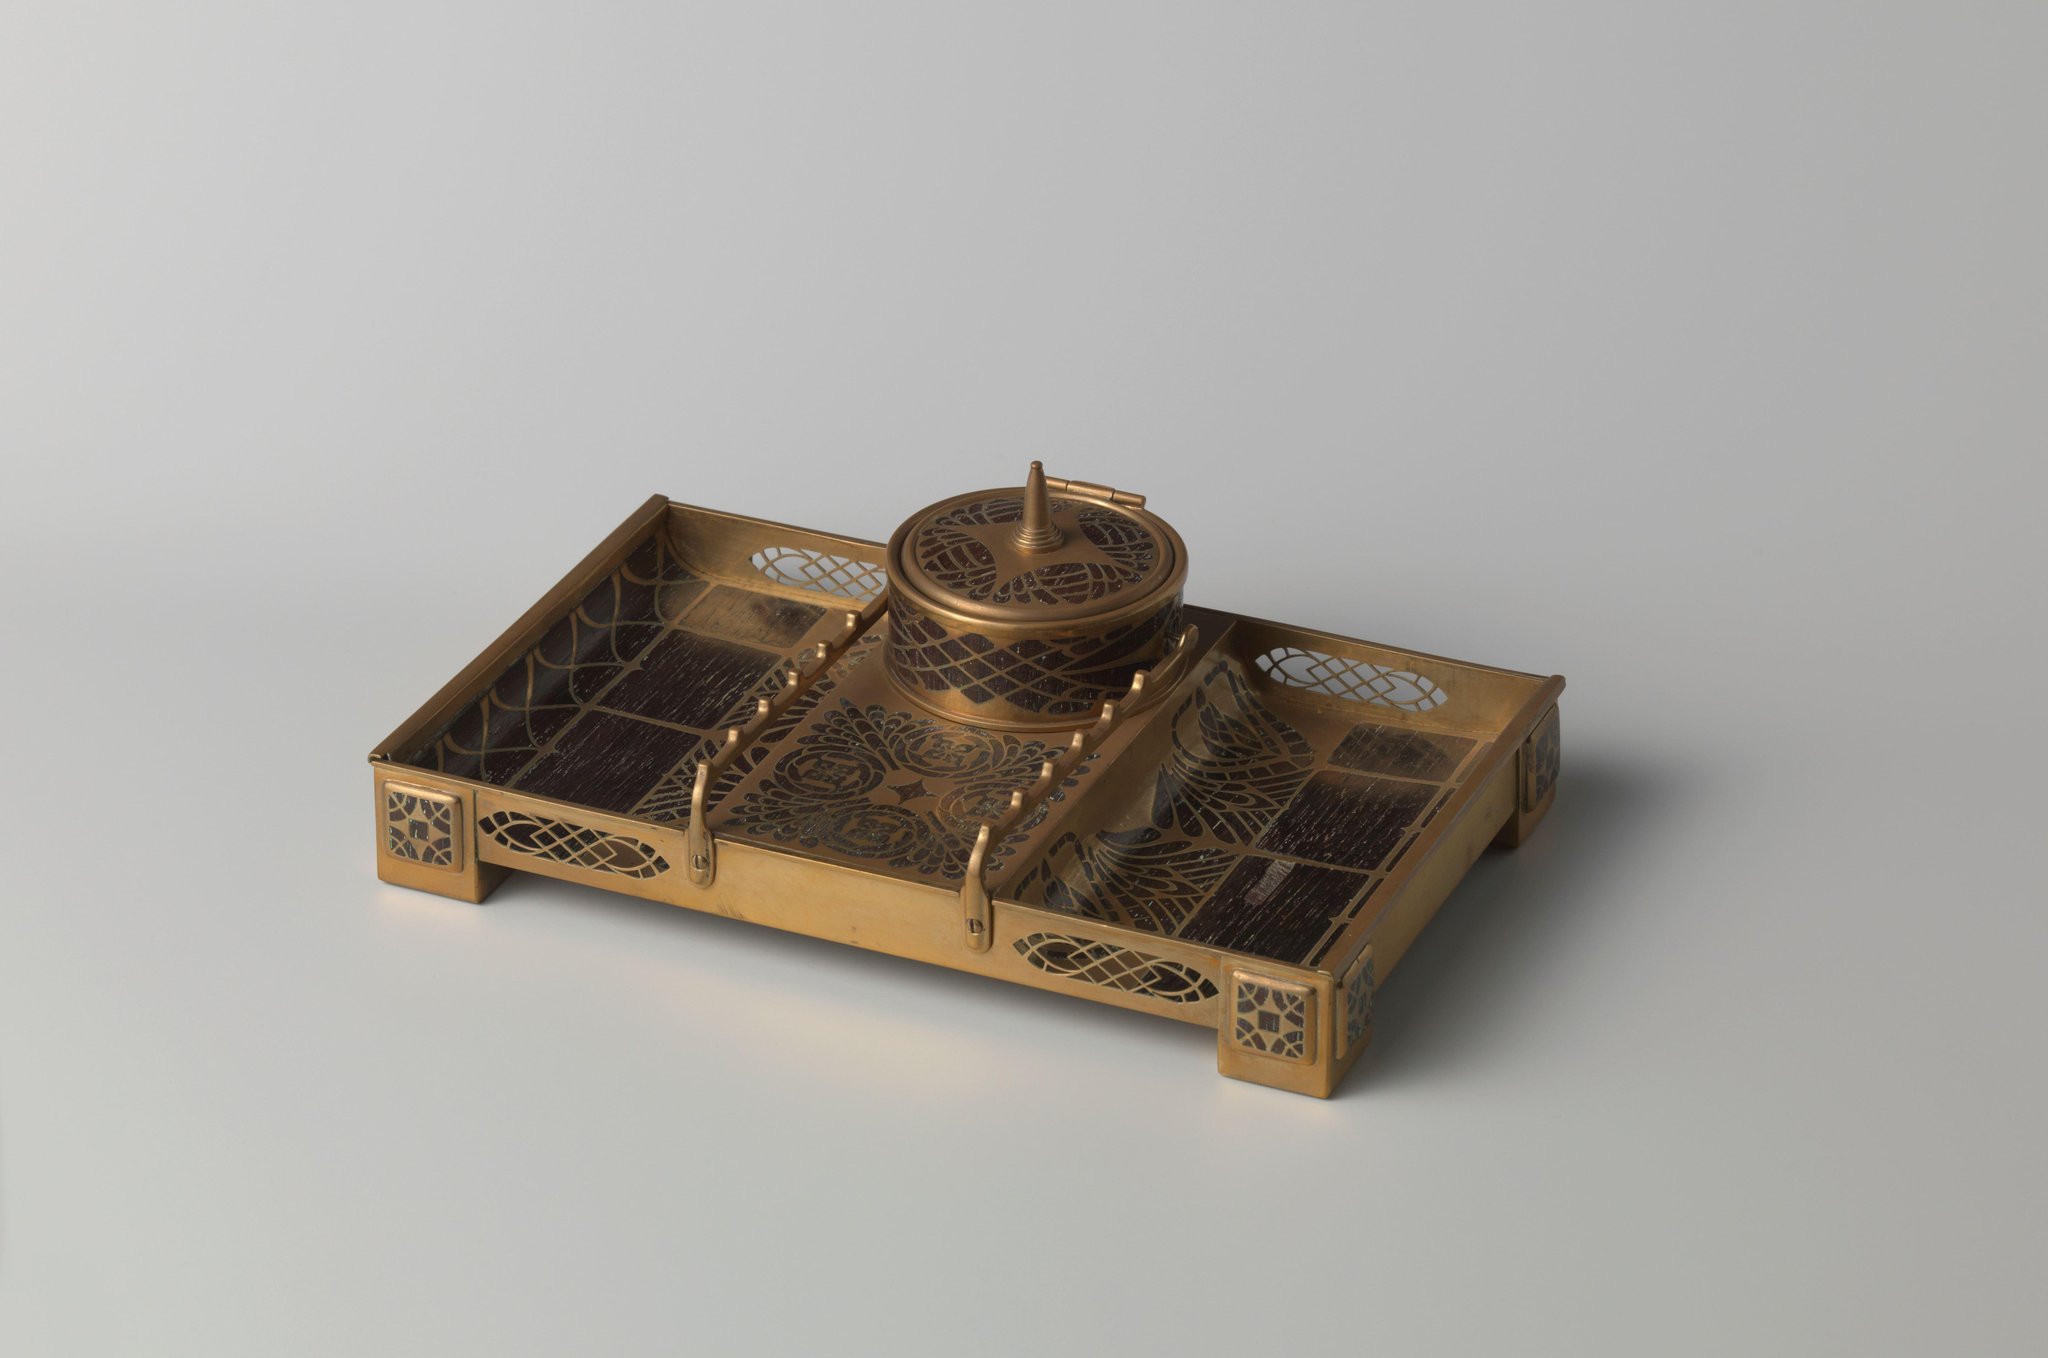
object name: inkstand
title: Inktstel van messing en tropisch hout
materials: brass, wood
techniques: cutting, inlay, punching, screwed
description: Het rechthoekige, op vier voeten geplaatste voorwerp, dat uit diverse onderdelen is samengesteld, is aan onder- en zijkanten geheel en op het verhoogde middendeel hoofdzakelijk in messing uitgevoerd of daarmee bekleed. Op het middendeel is een ronde inktpot met een door een scharnier bevestigd deksel met spitse knop geplaatst, alsmede twee geribde staven, waarop schrijfgerei gelegd kan worden. Aan weerszijden bevinden zich twee bakken. De messing opstaande wanden aan voor- en achterzijde van het inktstel zijn ajour bewerkt op de plaats, waar zij de afsluiting van de bakken vormen. Het oppervlak van de bakken, de bovenkant aan de voorzijde van het middendeel, de inktpot met ht deksel alsook de opstaande zijden van de voetenzijn versierd met messing bladwerk en een tropische houtsoort uitgezaagd gestileerd strak ornament, waarin bloem- en knopmotieven te herkennen zijn.